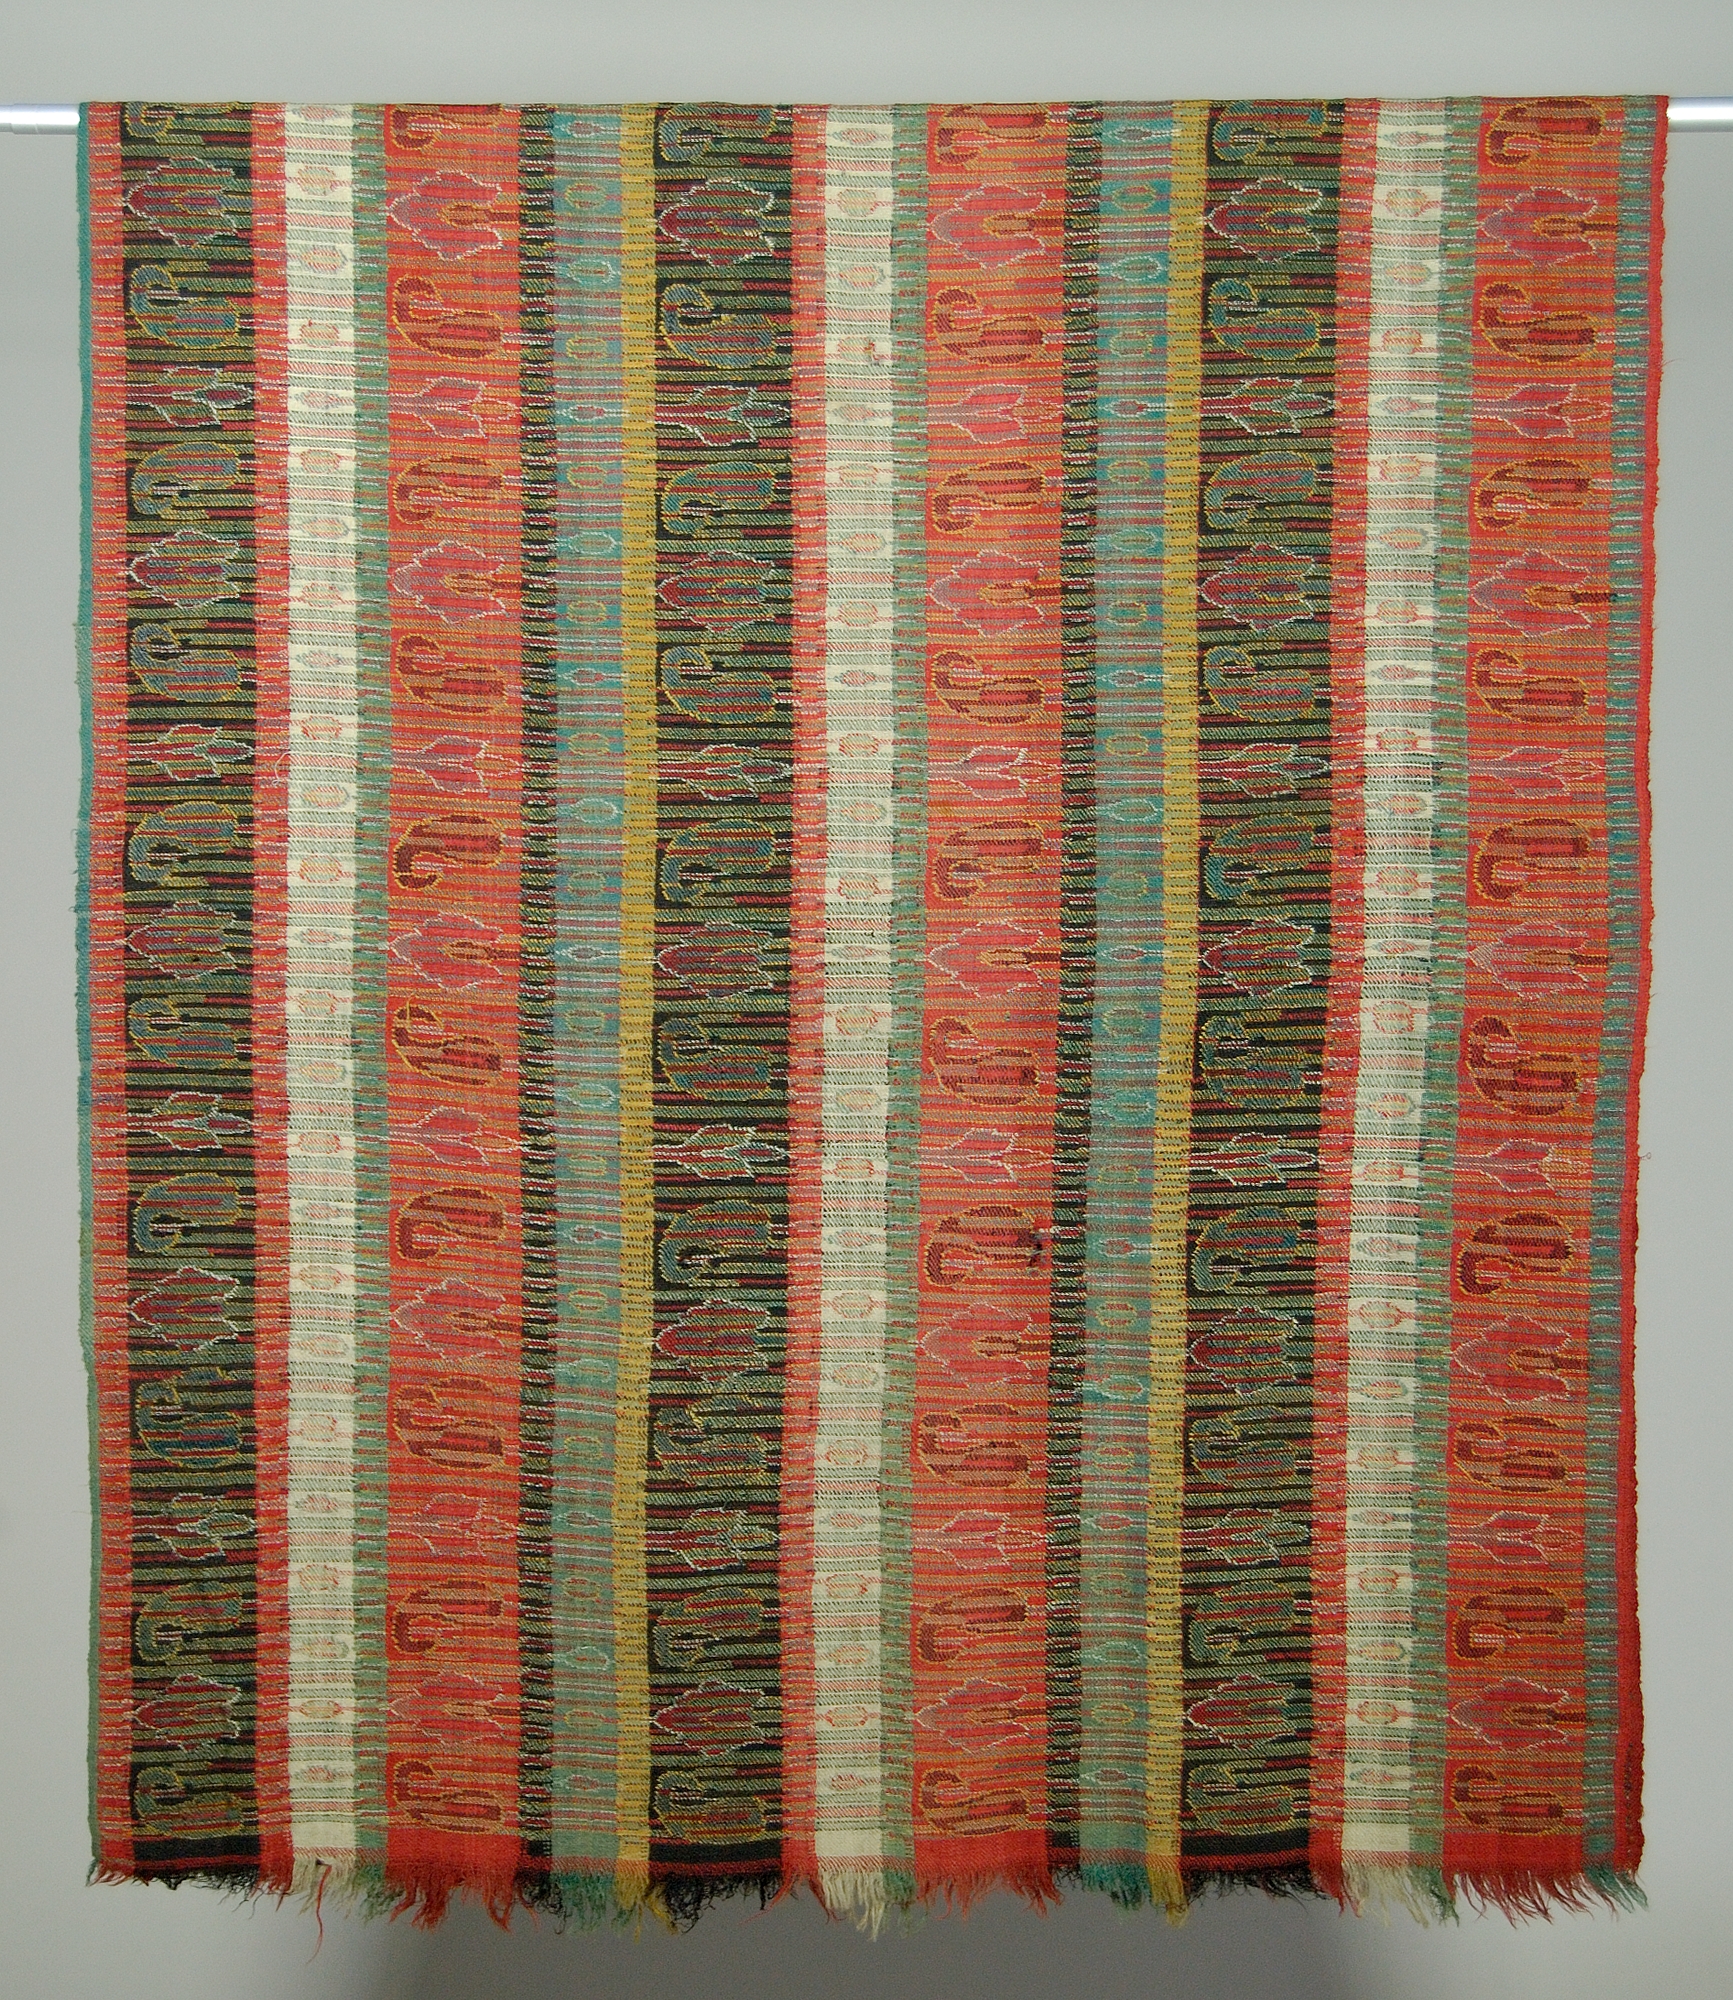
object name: shawl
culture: american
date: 1851-1875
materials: wool